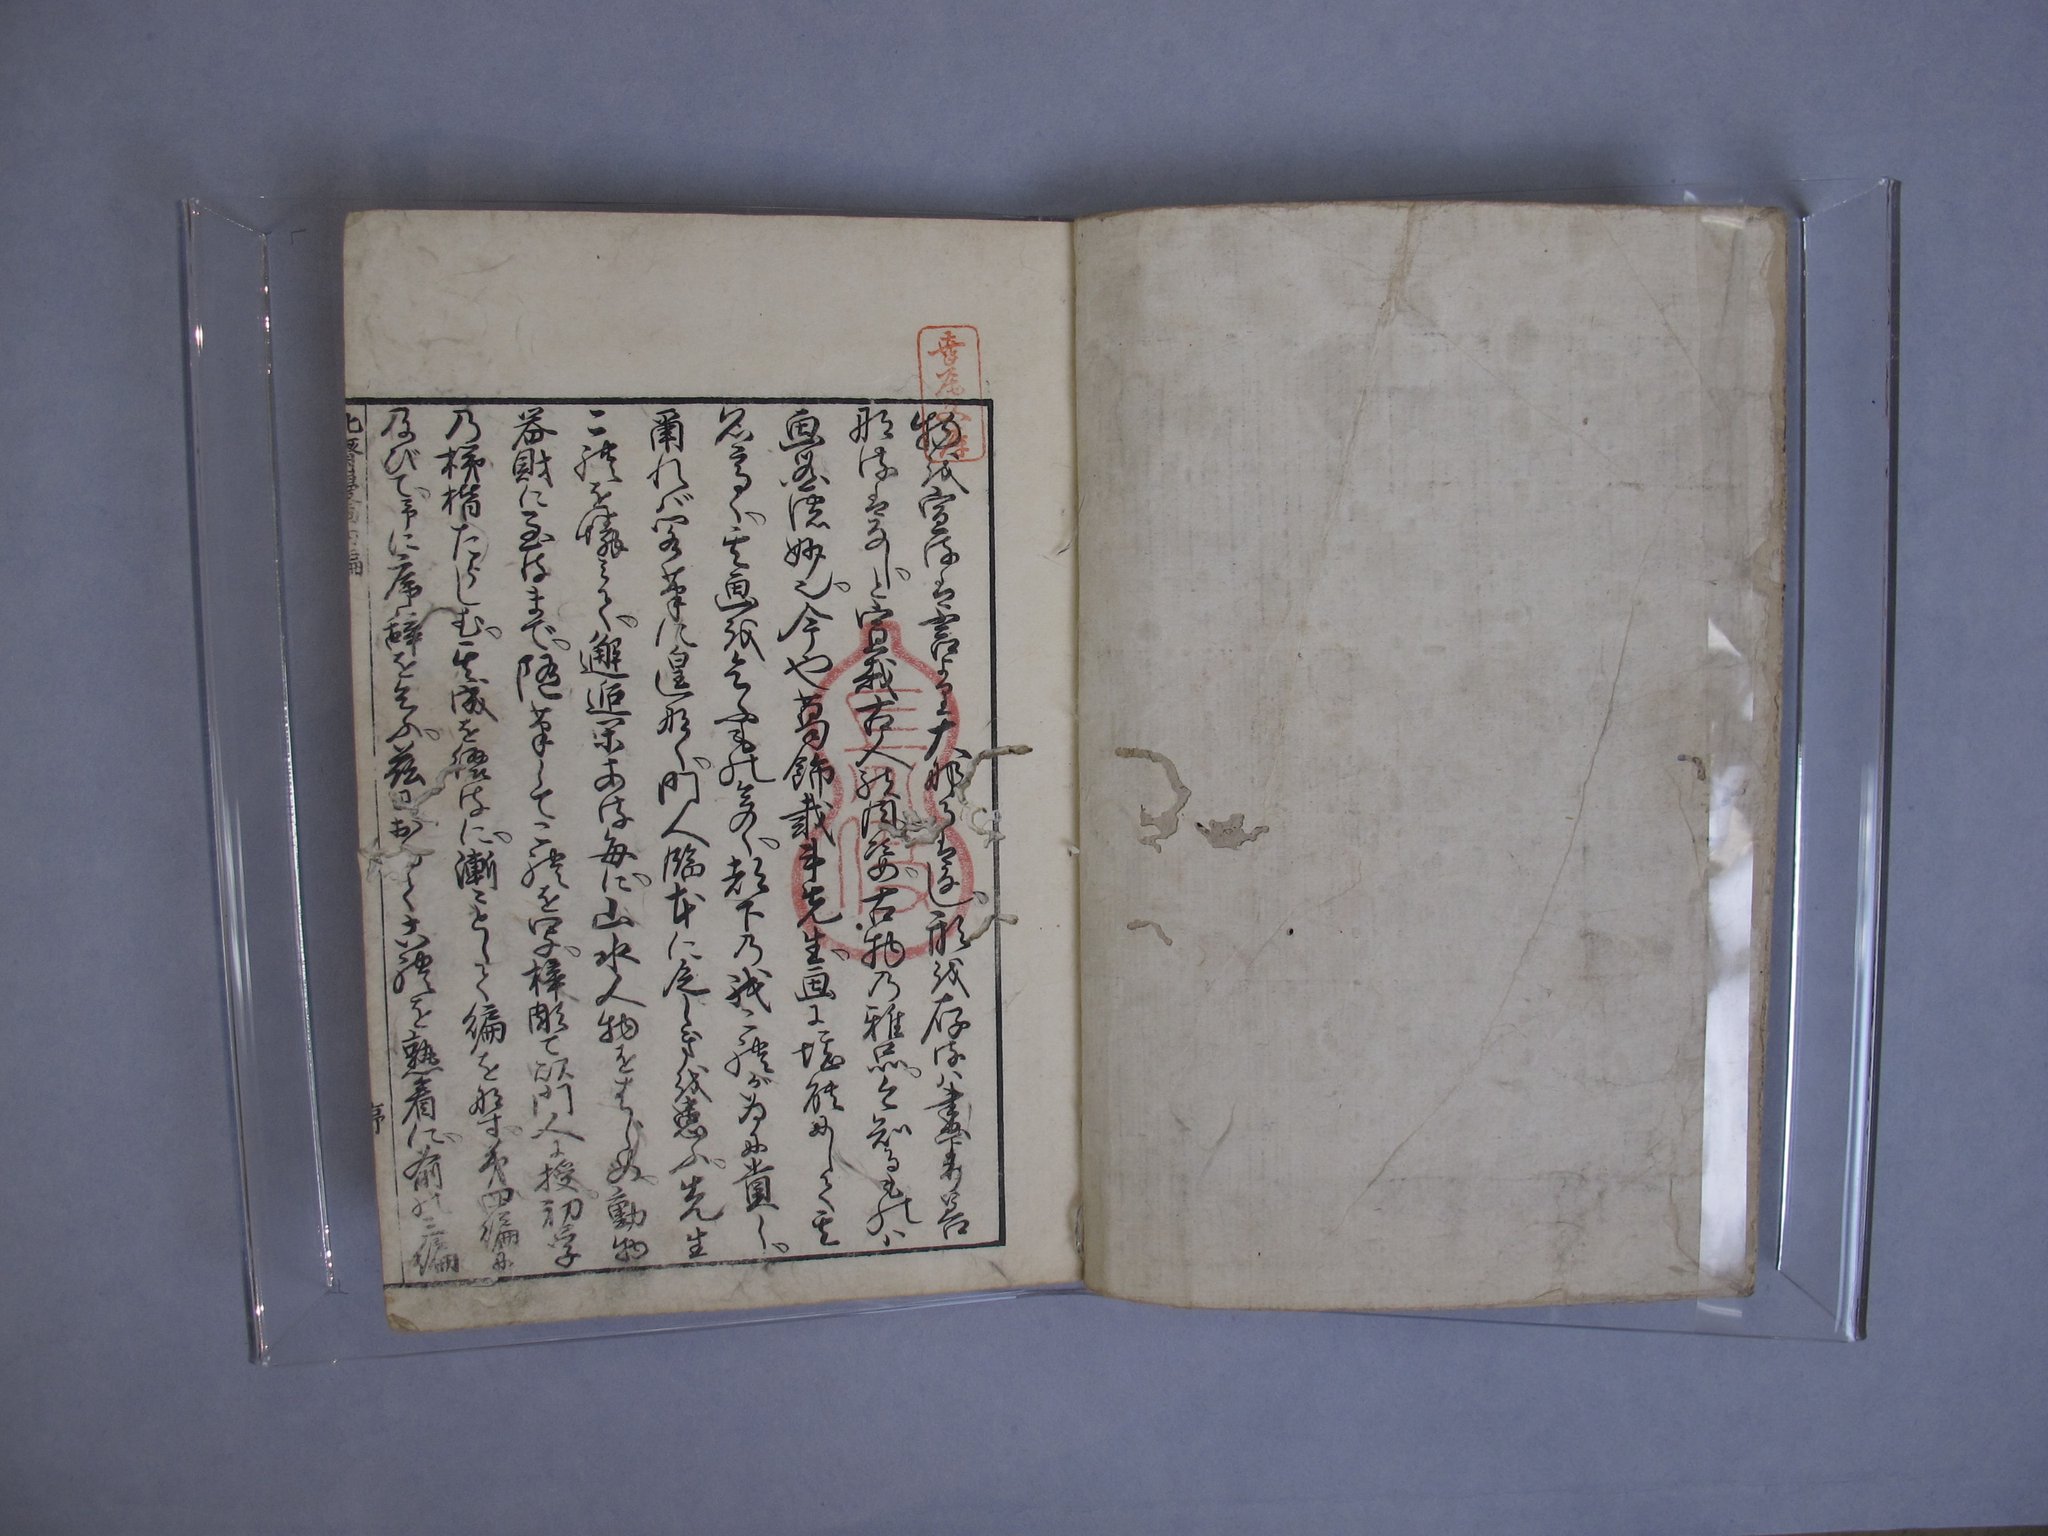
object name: illustrated book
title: Transmitting the Spirit, Revealing the Form of Things: Hokusai Sketchbooks, volume 4 (Denshin kaishu: Hokusai manga, yonhen)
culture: japanese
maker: katsushika hokusai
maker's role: artist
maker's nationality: japanese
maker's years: 1760-1849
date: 1819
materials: ink, paper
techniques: woodblock print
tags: human figures